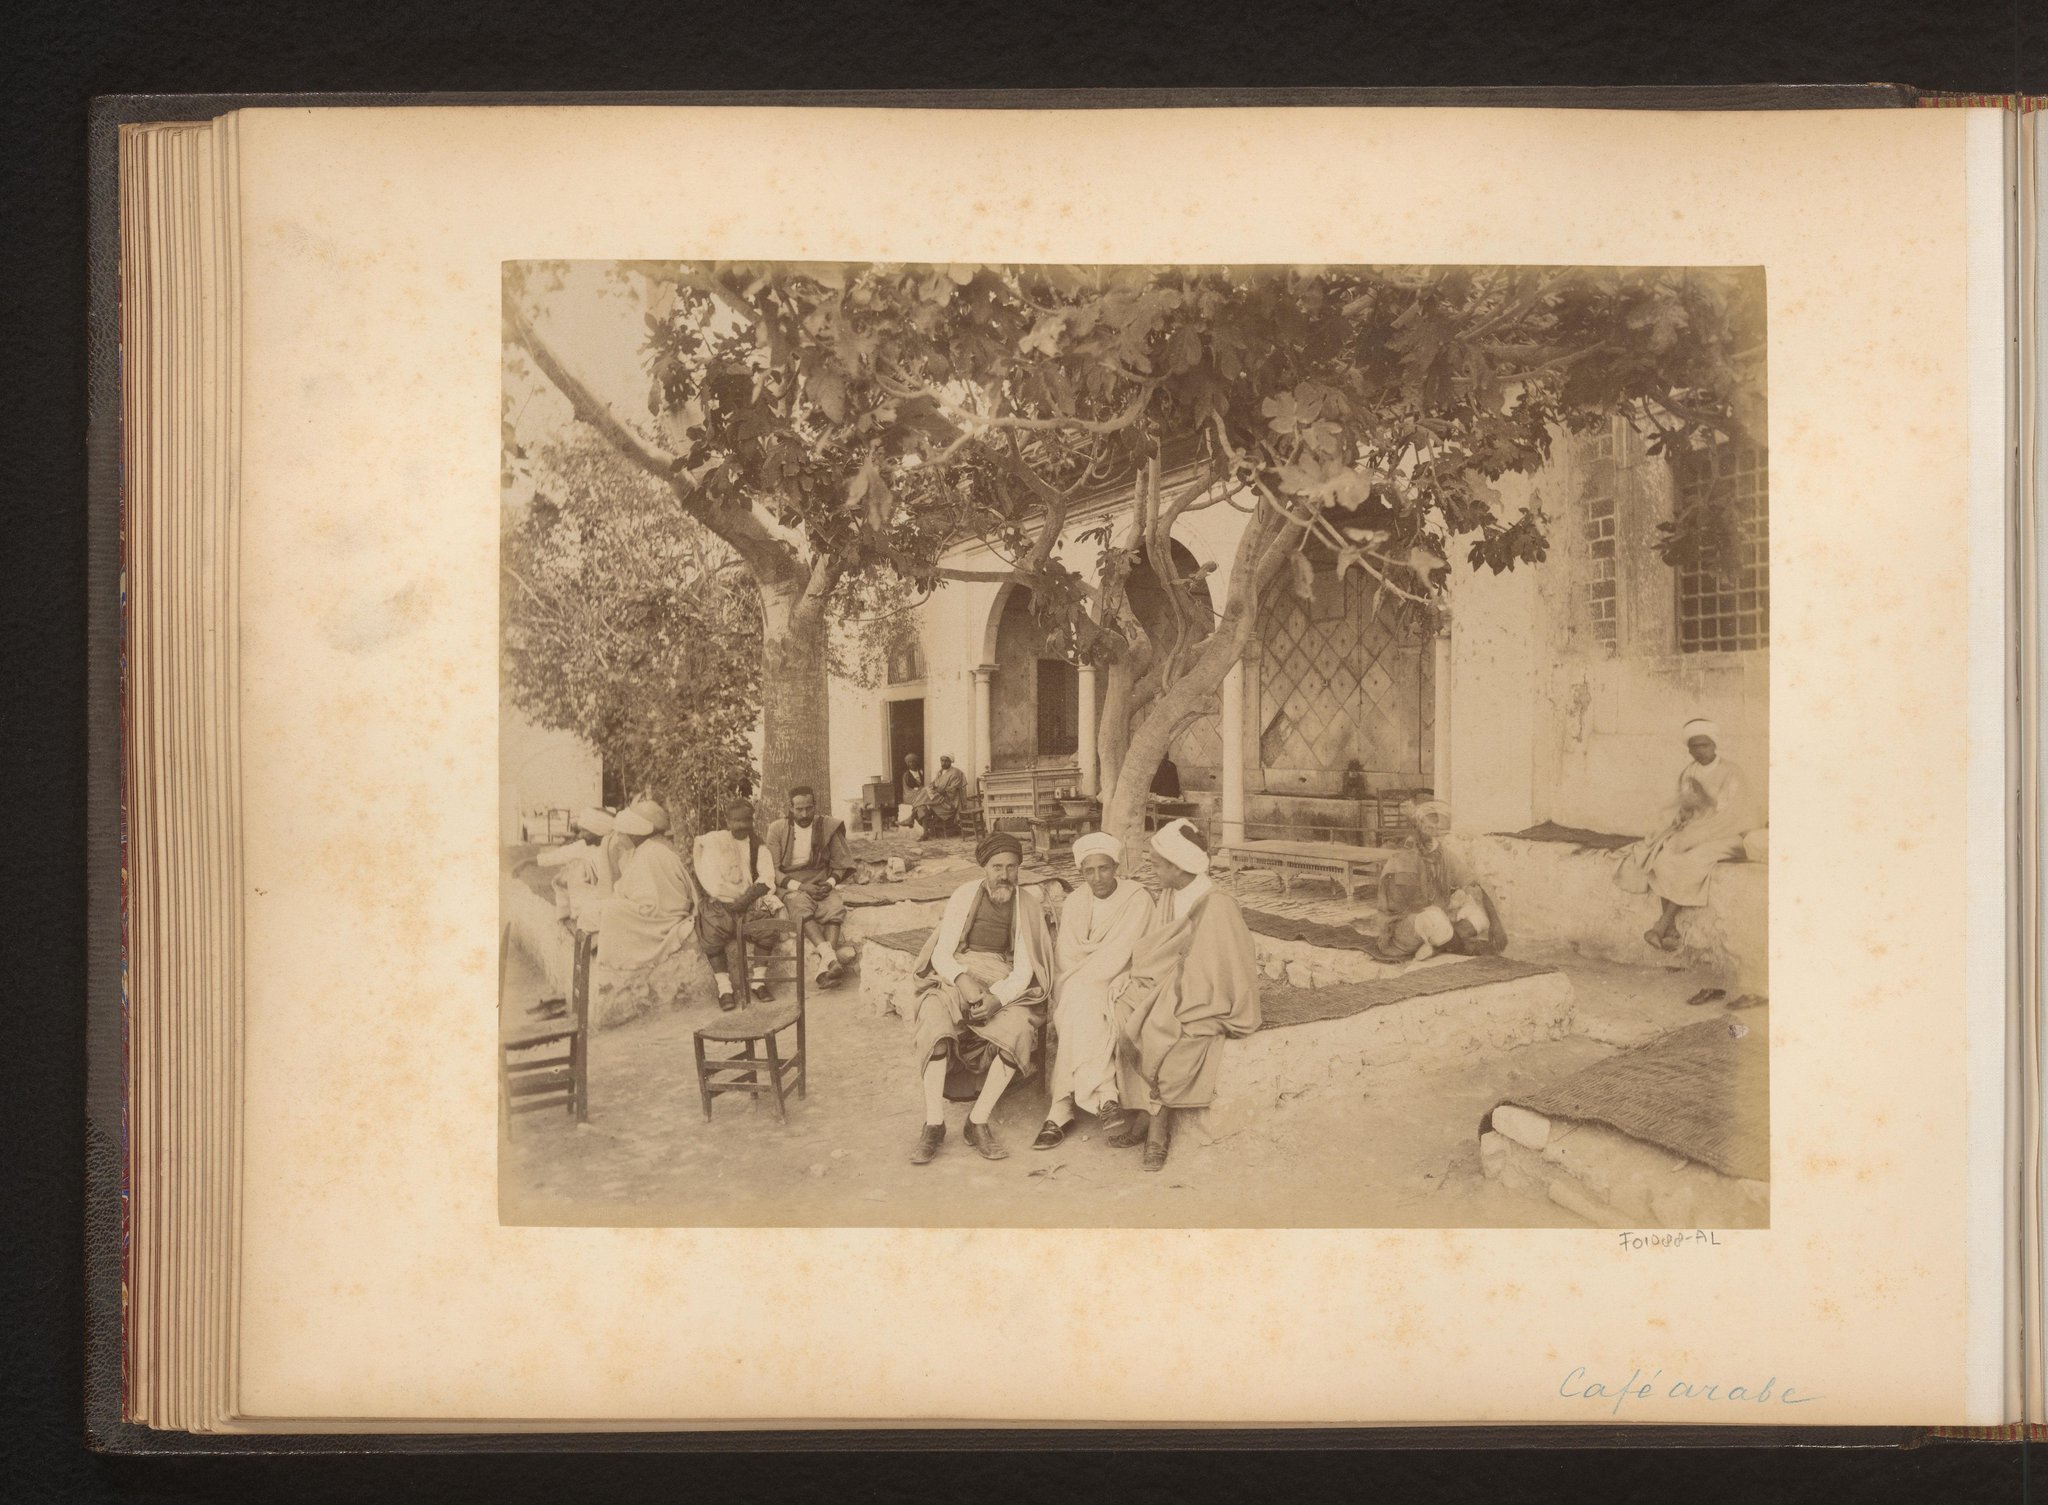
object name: photograph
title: Mannen onder een boom op plein bij een café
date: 1880-1900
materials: photographic support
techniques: albumen print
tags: trees, historical persons, inn, coffee-house, public house, etc.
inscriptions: annotation: ‘café arabe’, check stamp: ‘J. Kuhn Editeur/ 220 Rue de Rivoli Paris’